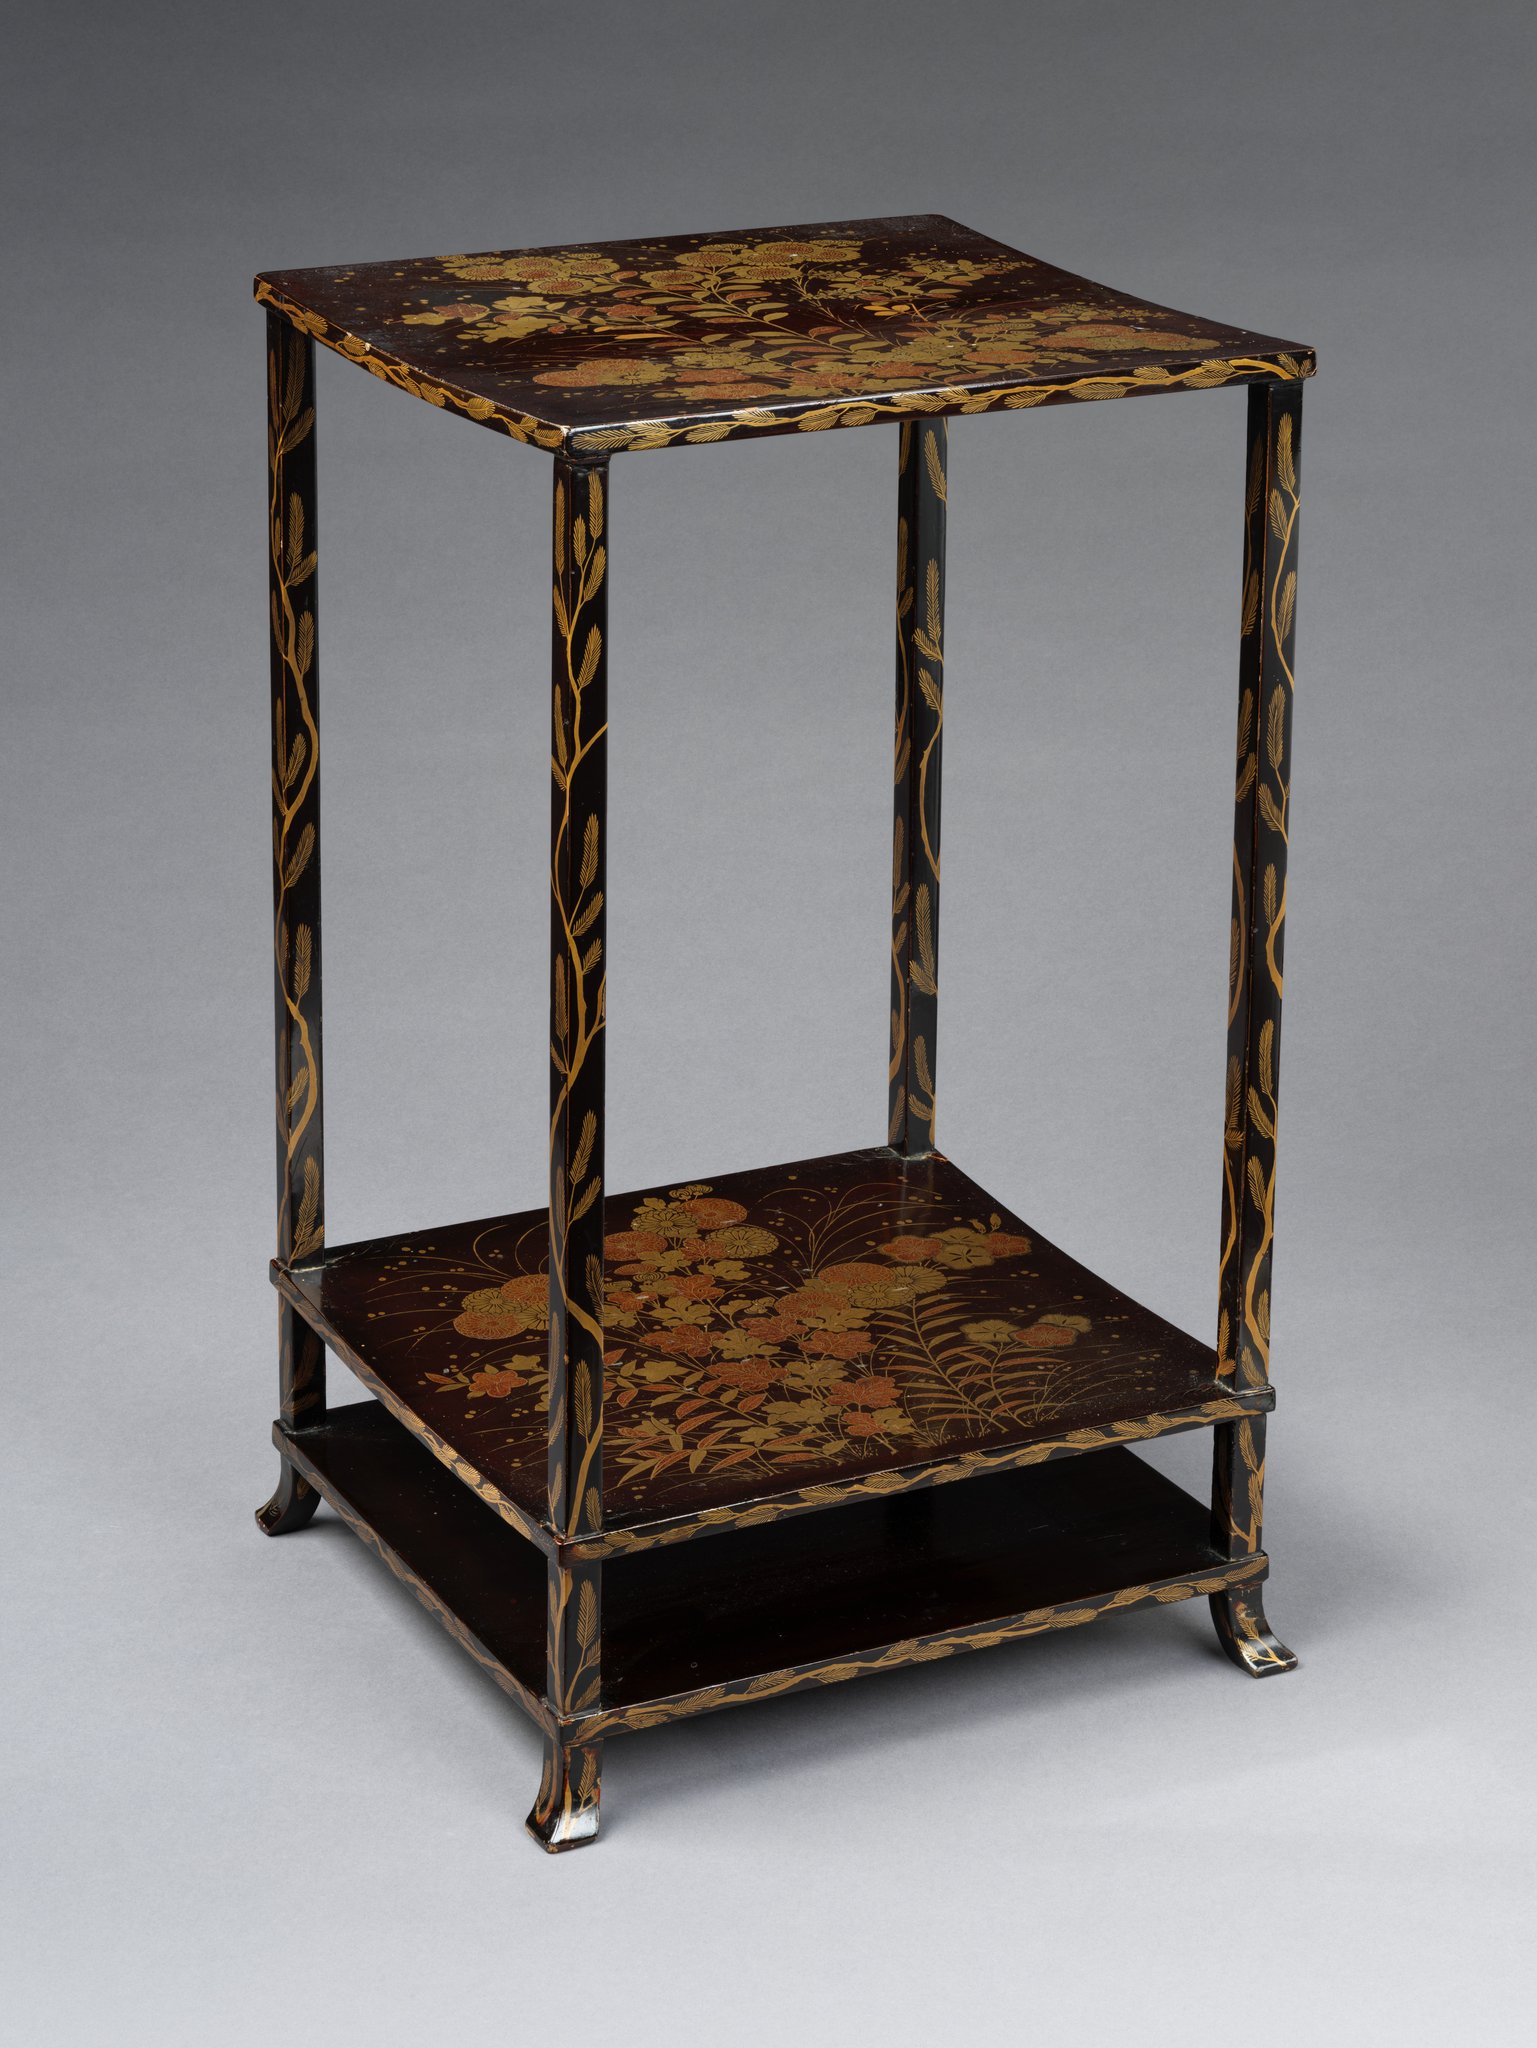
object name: table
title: Stand with Autumn Grasses and Flowers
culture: japanese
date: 1601-1650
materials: gold, wood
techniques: hiramakie, lacquer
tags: flowers